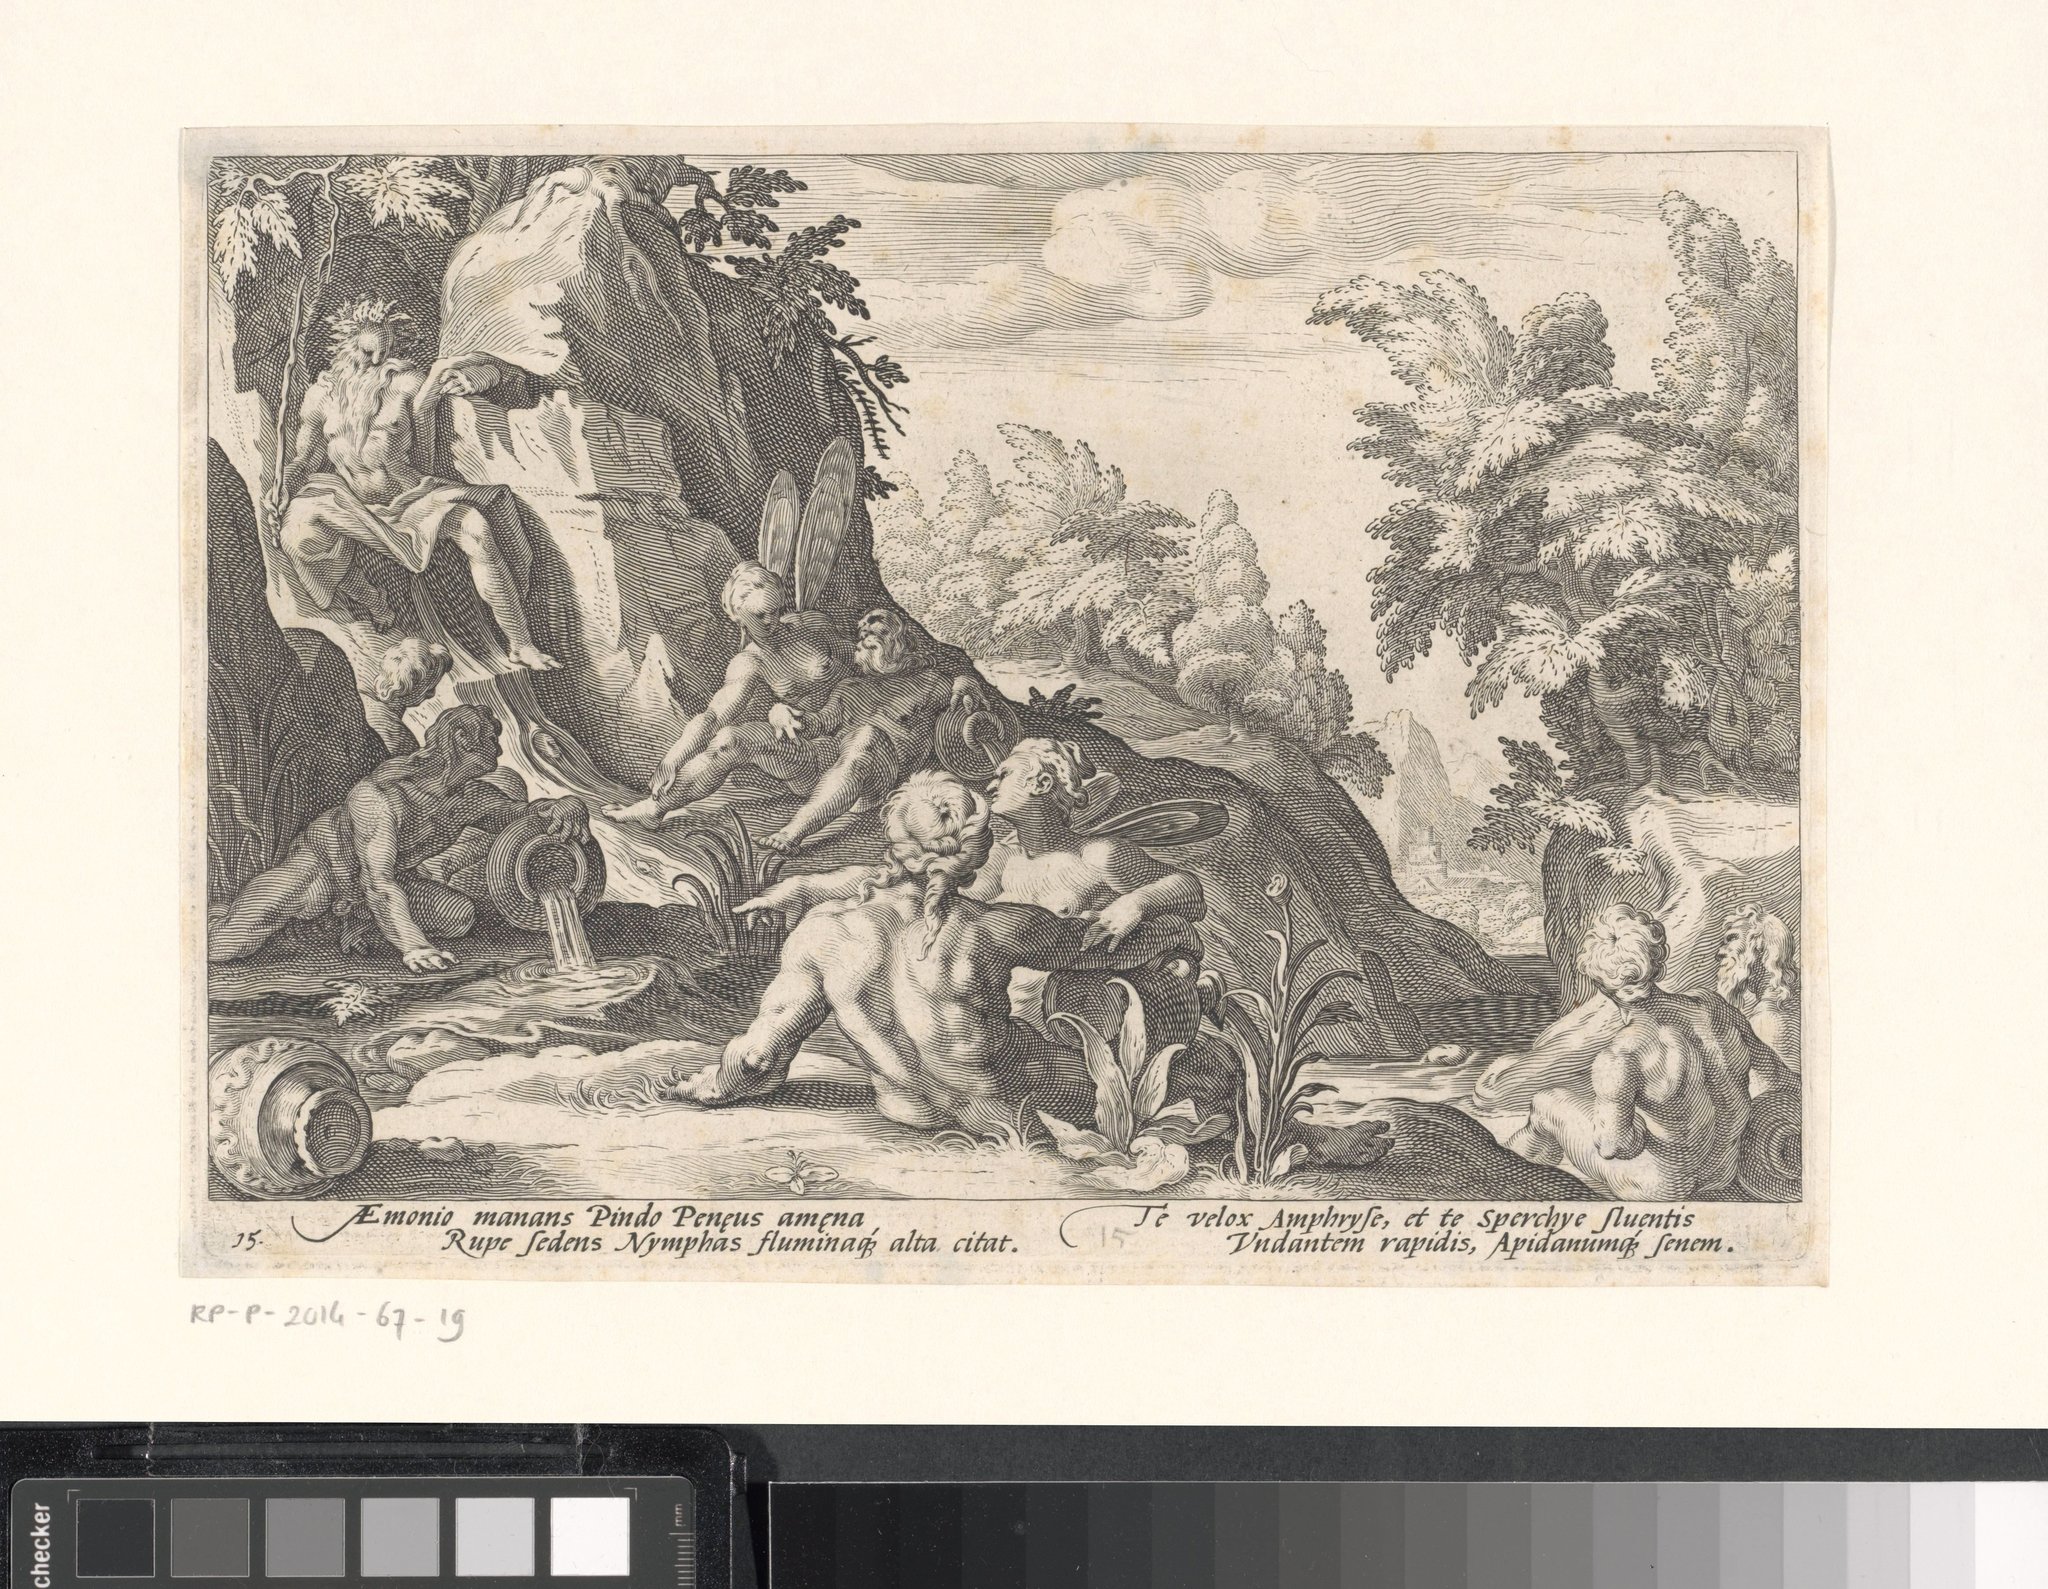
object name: print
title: Riviergod Peneus te midden van goden en nimfen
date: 1589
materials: paper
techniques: engraving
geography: haarlem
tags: the river-gods condole with peneus for the loss of daphne transformed into a tree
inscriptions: collector's mark: Lugt 11, collector's mark: ‘Hinloopen’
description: (Rivier)goden en nimfen zijn bijeengekomen bij de riviergod Peneus, die op een rots in een lommerrijk landschap zit. Mogelijk tonen zij hun medeleven na de metamorfose van Peneus' dochter Daphne in een laurierboom. In de ondermarge een vierregelige toelichting, in twee kolommen, in het Latijn.